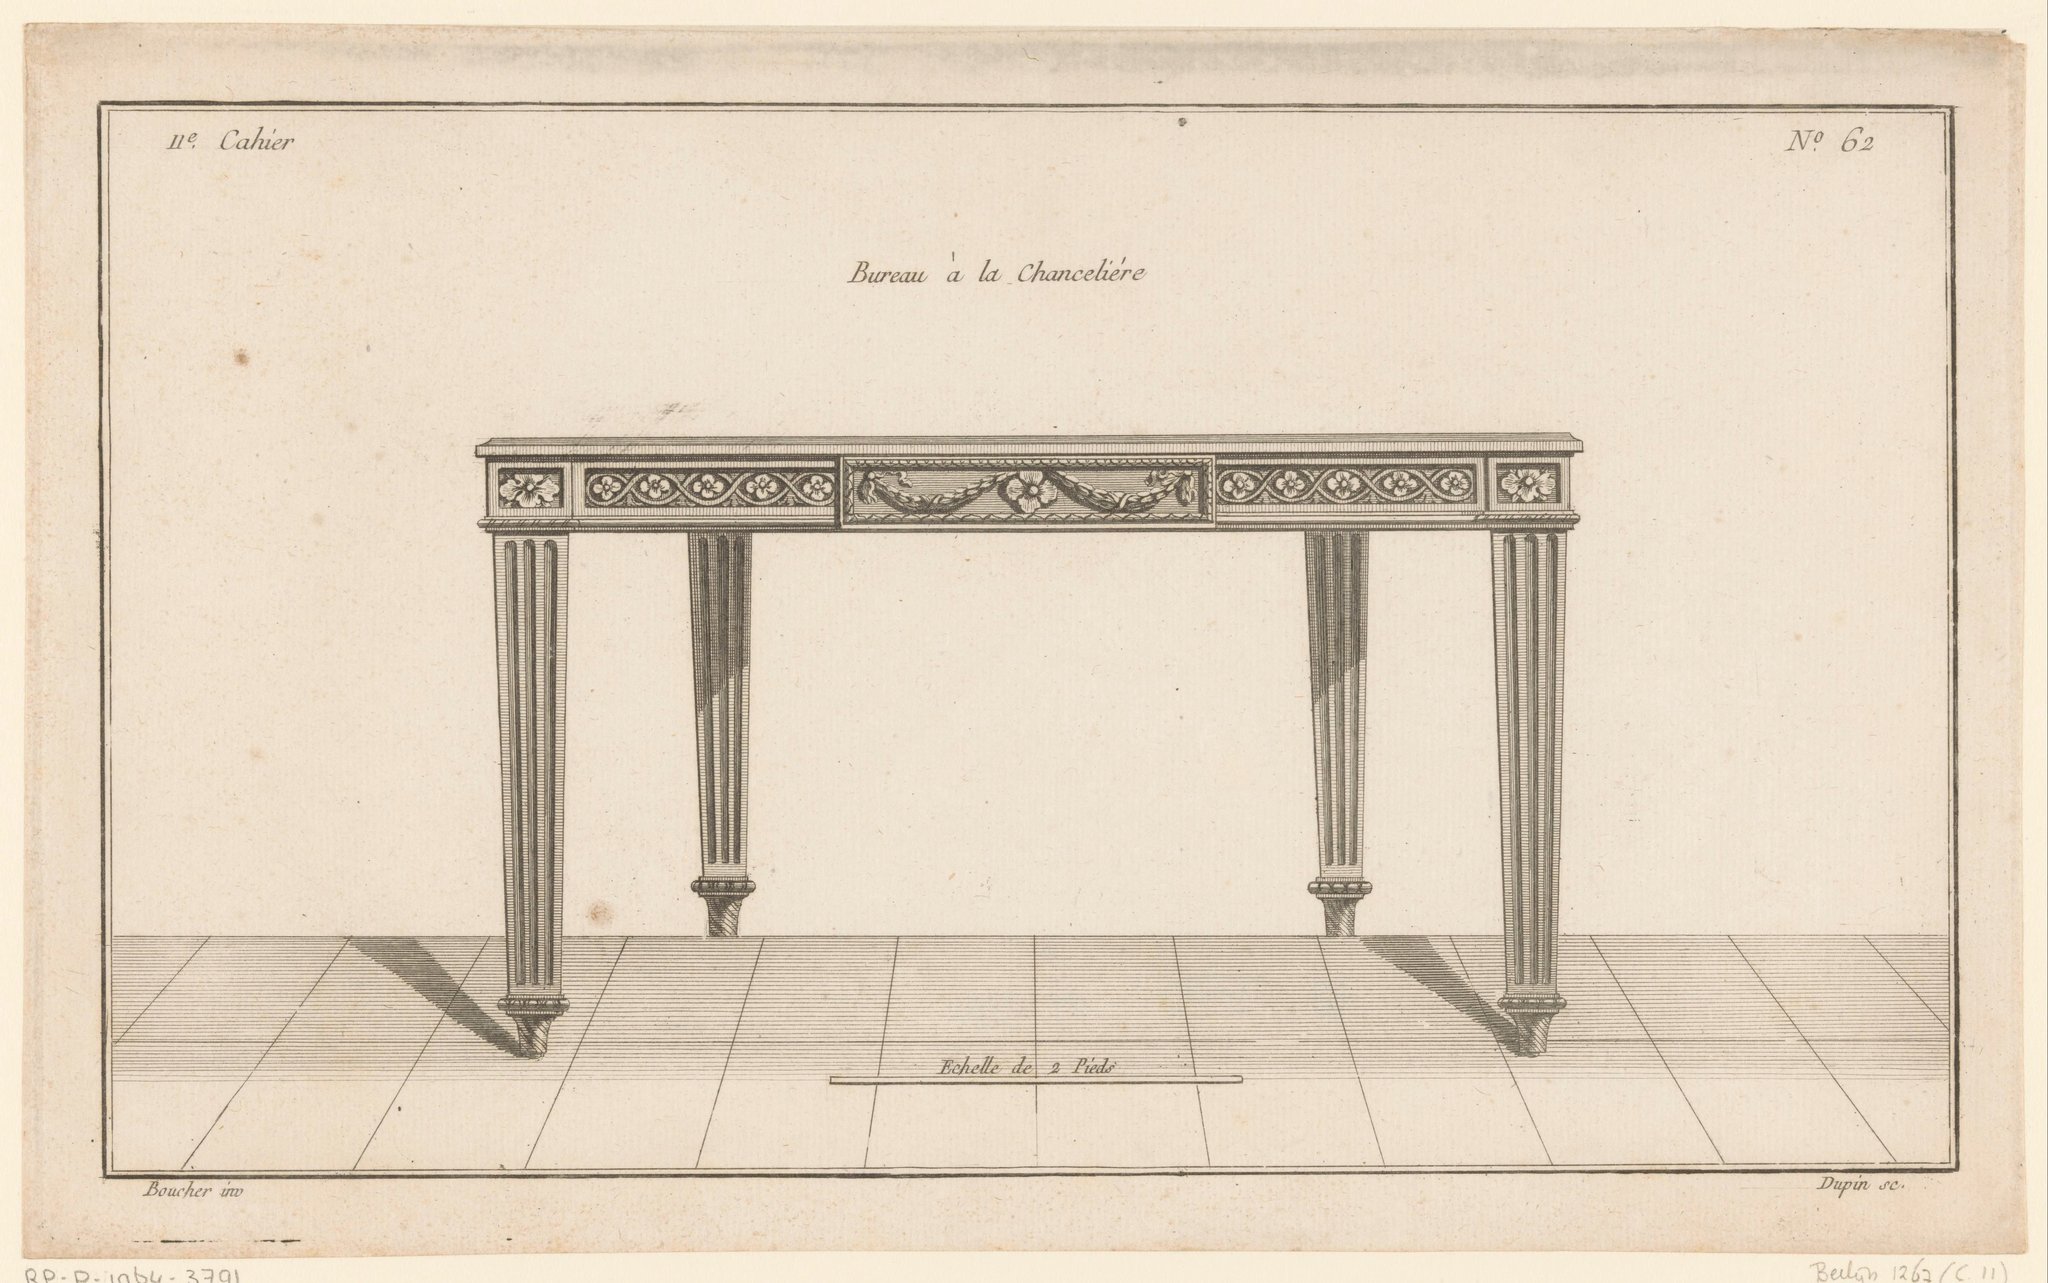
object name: ornament print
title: 11e Cahier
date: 1772-1779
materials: paper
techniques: engraving, etching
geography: paris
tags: writing-table, writing-desk, ornament ~ festoon, garland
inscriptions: collector's mark: Lugt 2228, collector's mark: Lugt 2760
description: Een geornamenteerd bureau met bloemmotieven en guirlandes. Prentnummer 62.